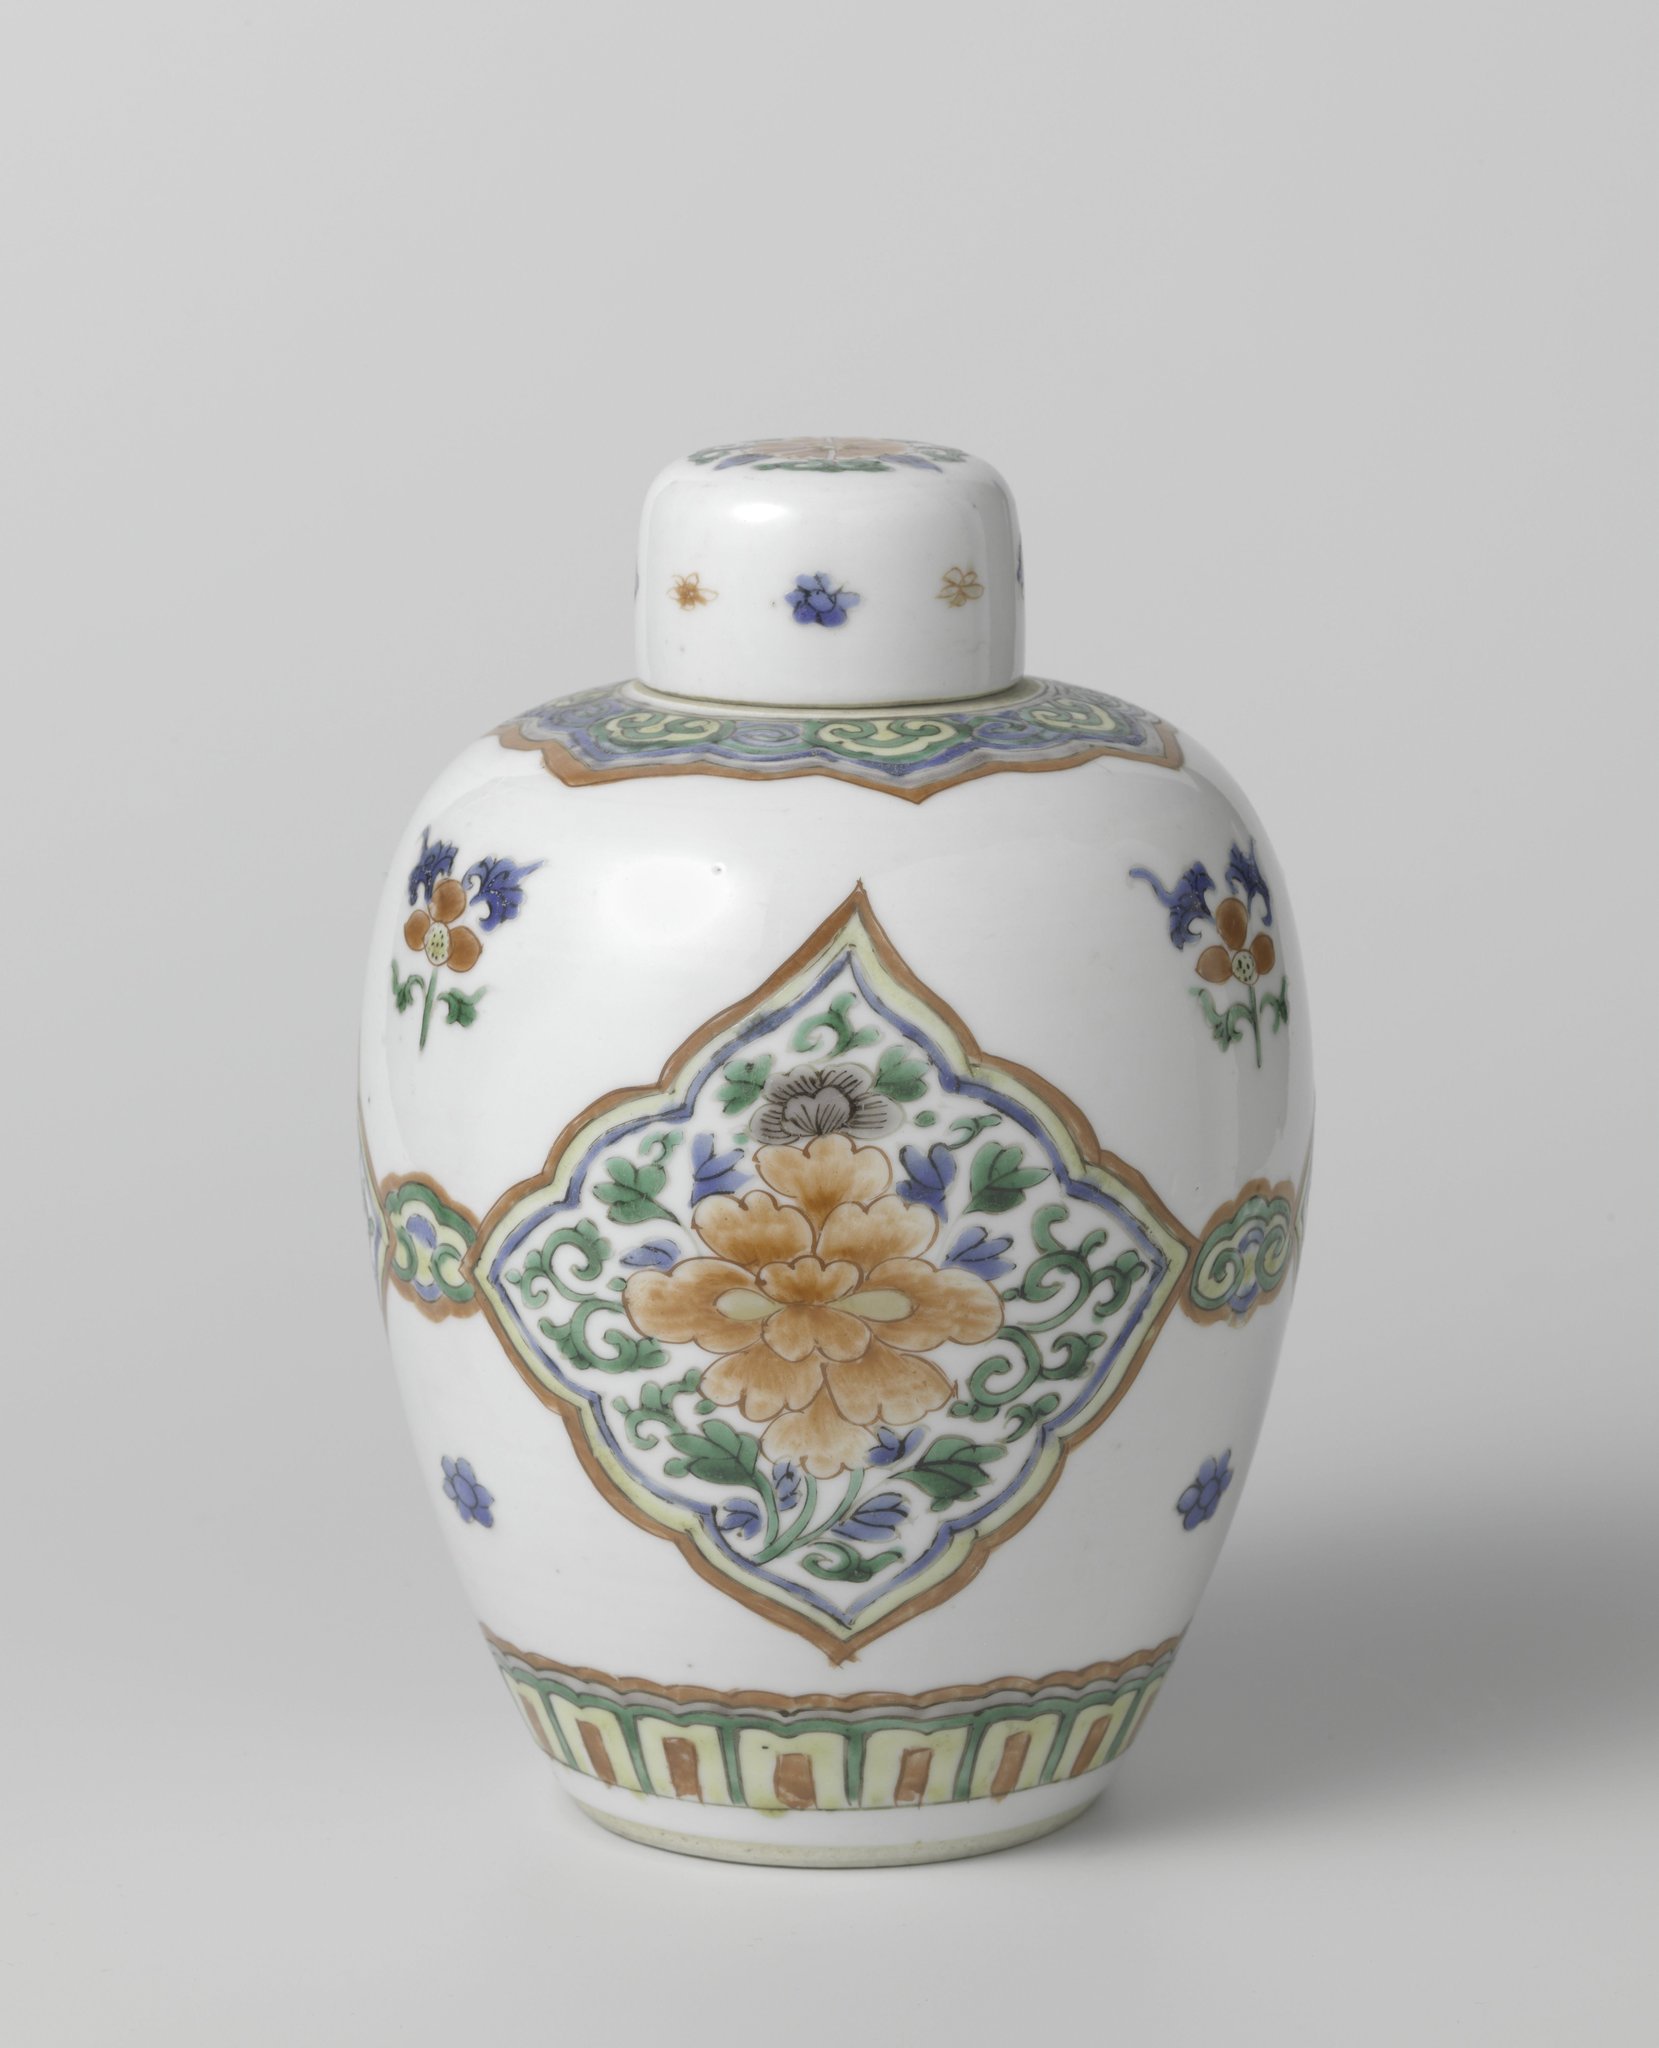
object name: lid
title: Covered jar with ruyi-heads and flowers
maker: Anonymous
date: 1700-1724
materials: glaze, paint, porcelain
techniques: firing, turning, vitrification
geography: china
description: Deksel van pot van porselein, beschilderd op het glazuur in blauw, rood, groen, geel, aubergine en zwart. Op de deksel een gestileerde pioenroos met takken en strooibloemen. Een barst in de deksel. Famille verte.